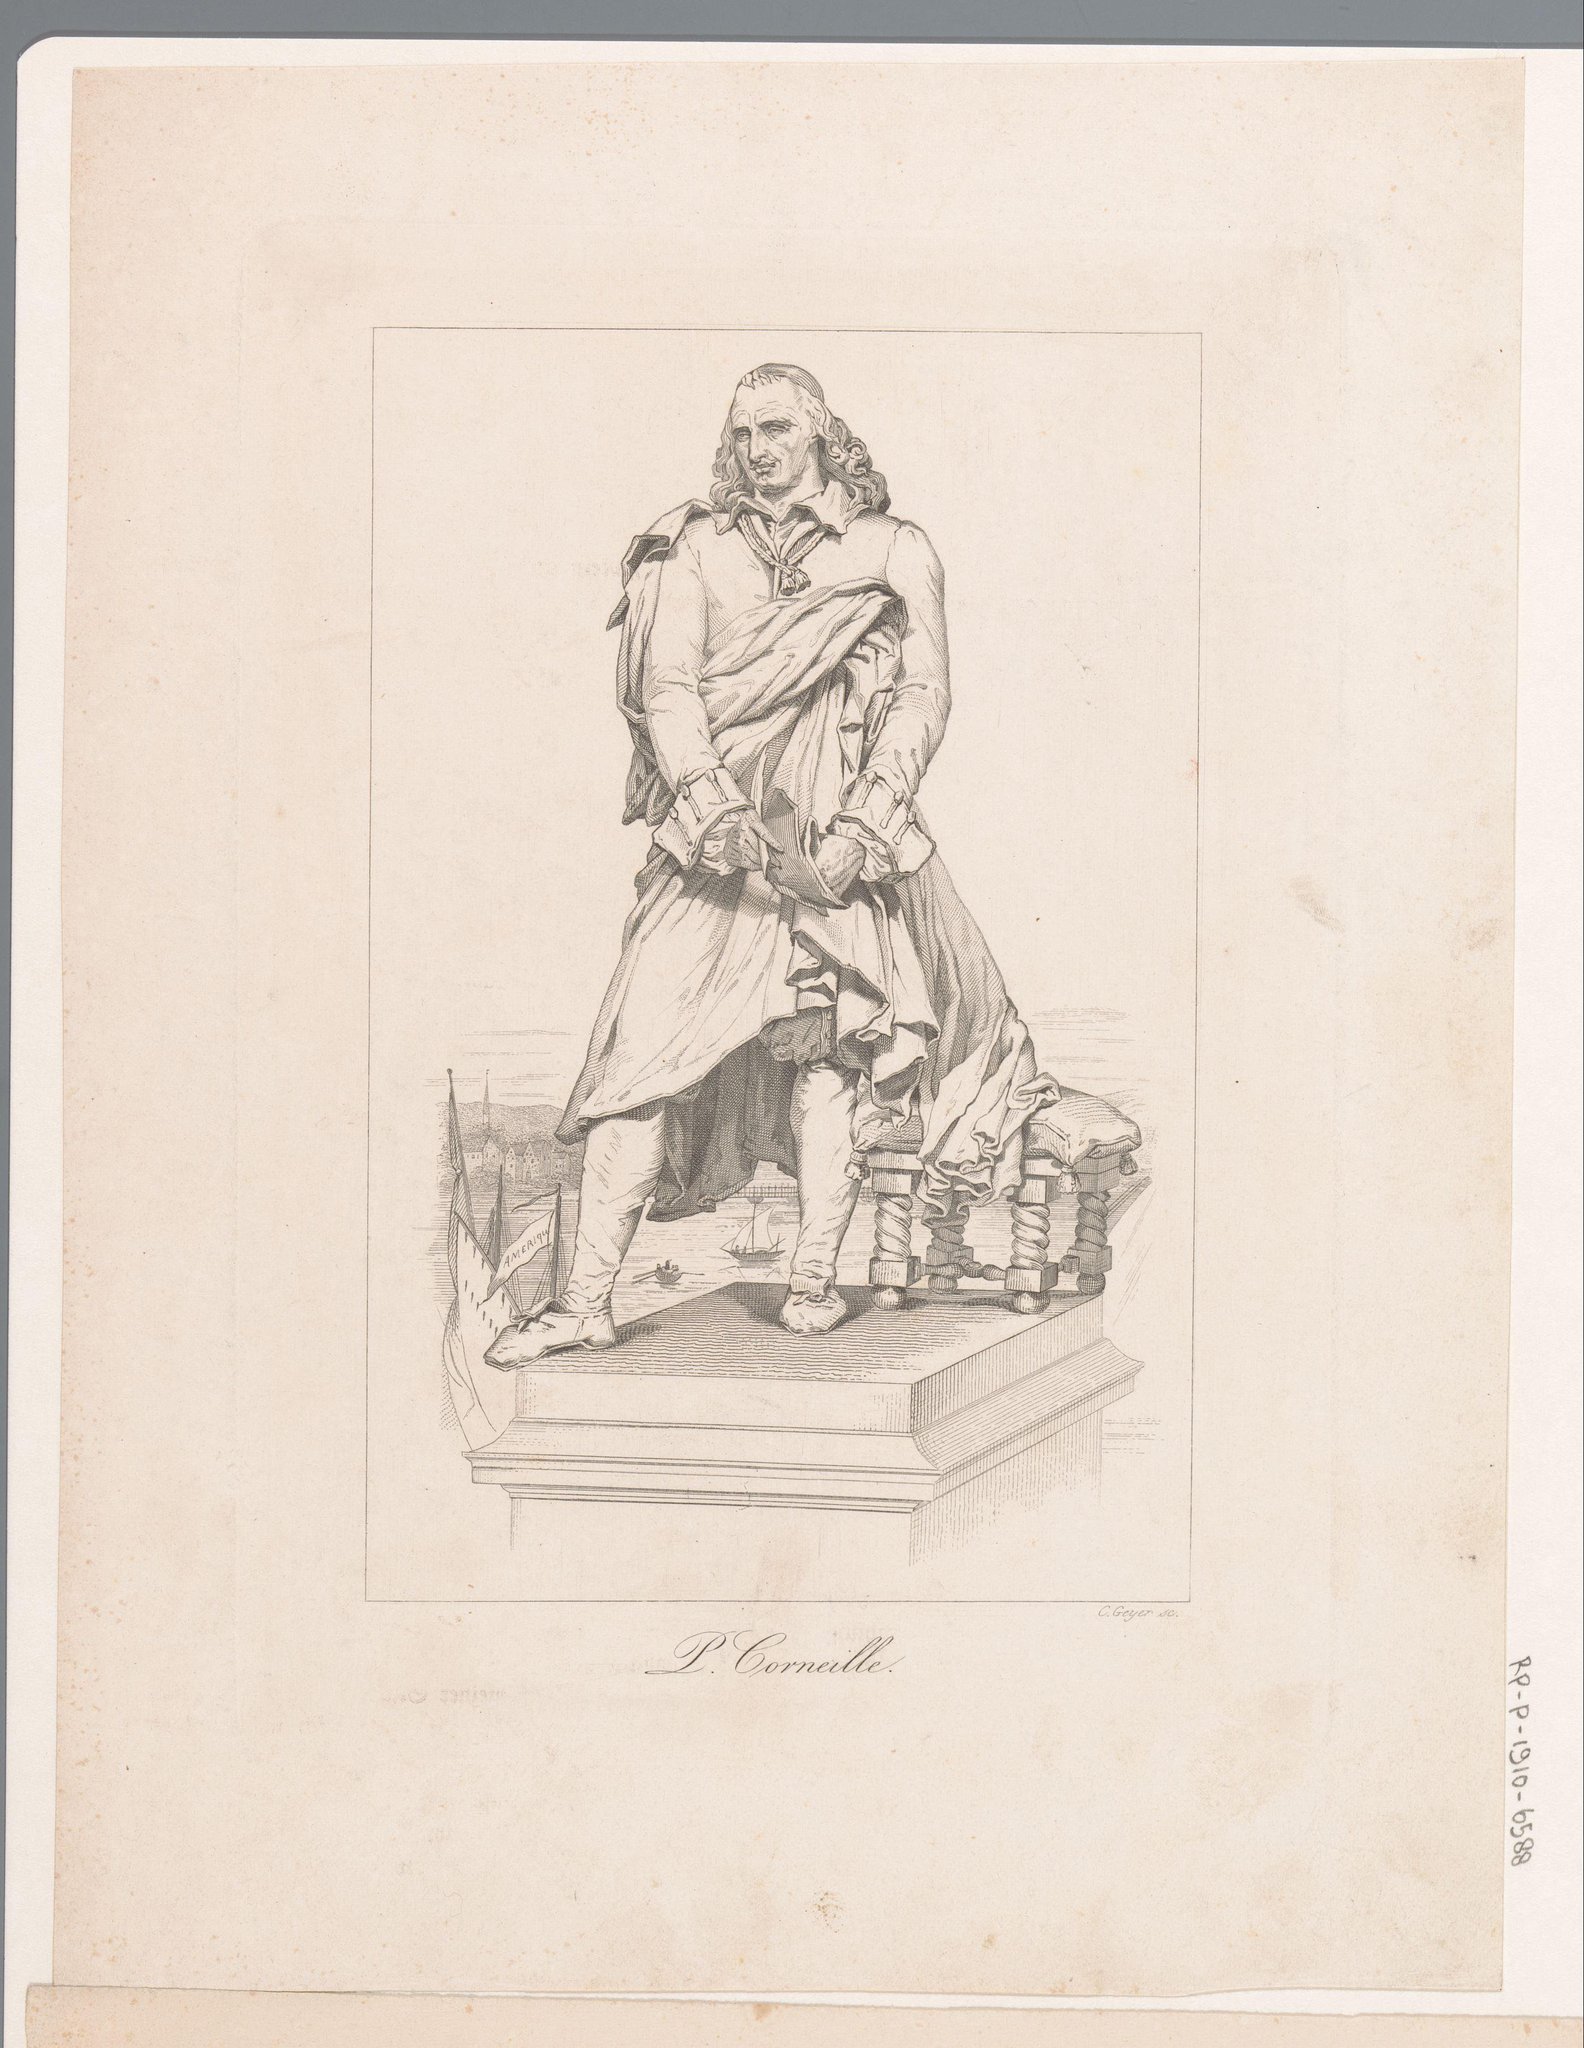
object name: print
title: Standbeeld van Pierre Corneille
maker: conrad geyer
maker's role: print maker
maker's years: 1816-1893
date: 1826-1893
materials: paper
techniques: engraving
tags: pierre corneille, river, historical persons, sculpture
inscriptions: collector's mark: Lugt 2228